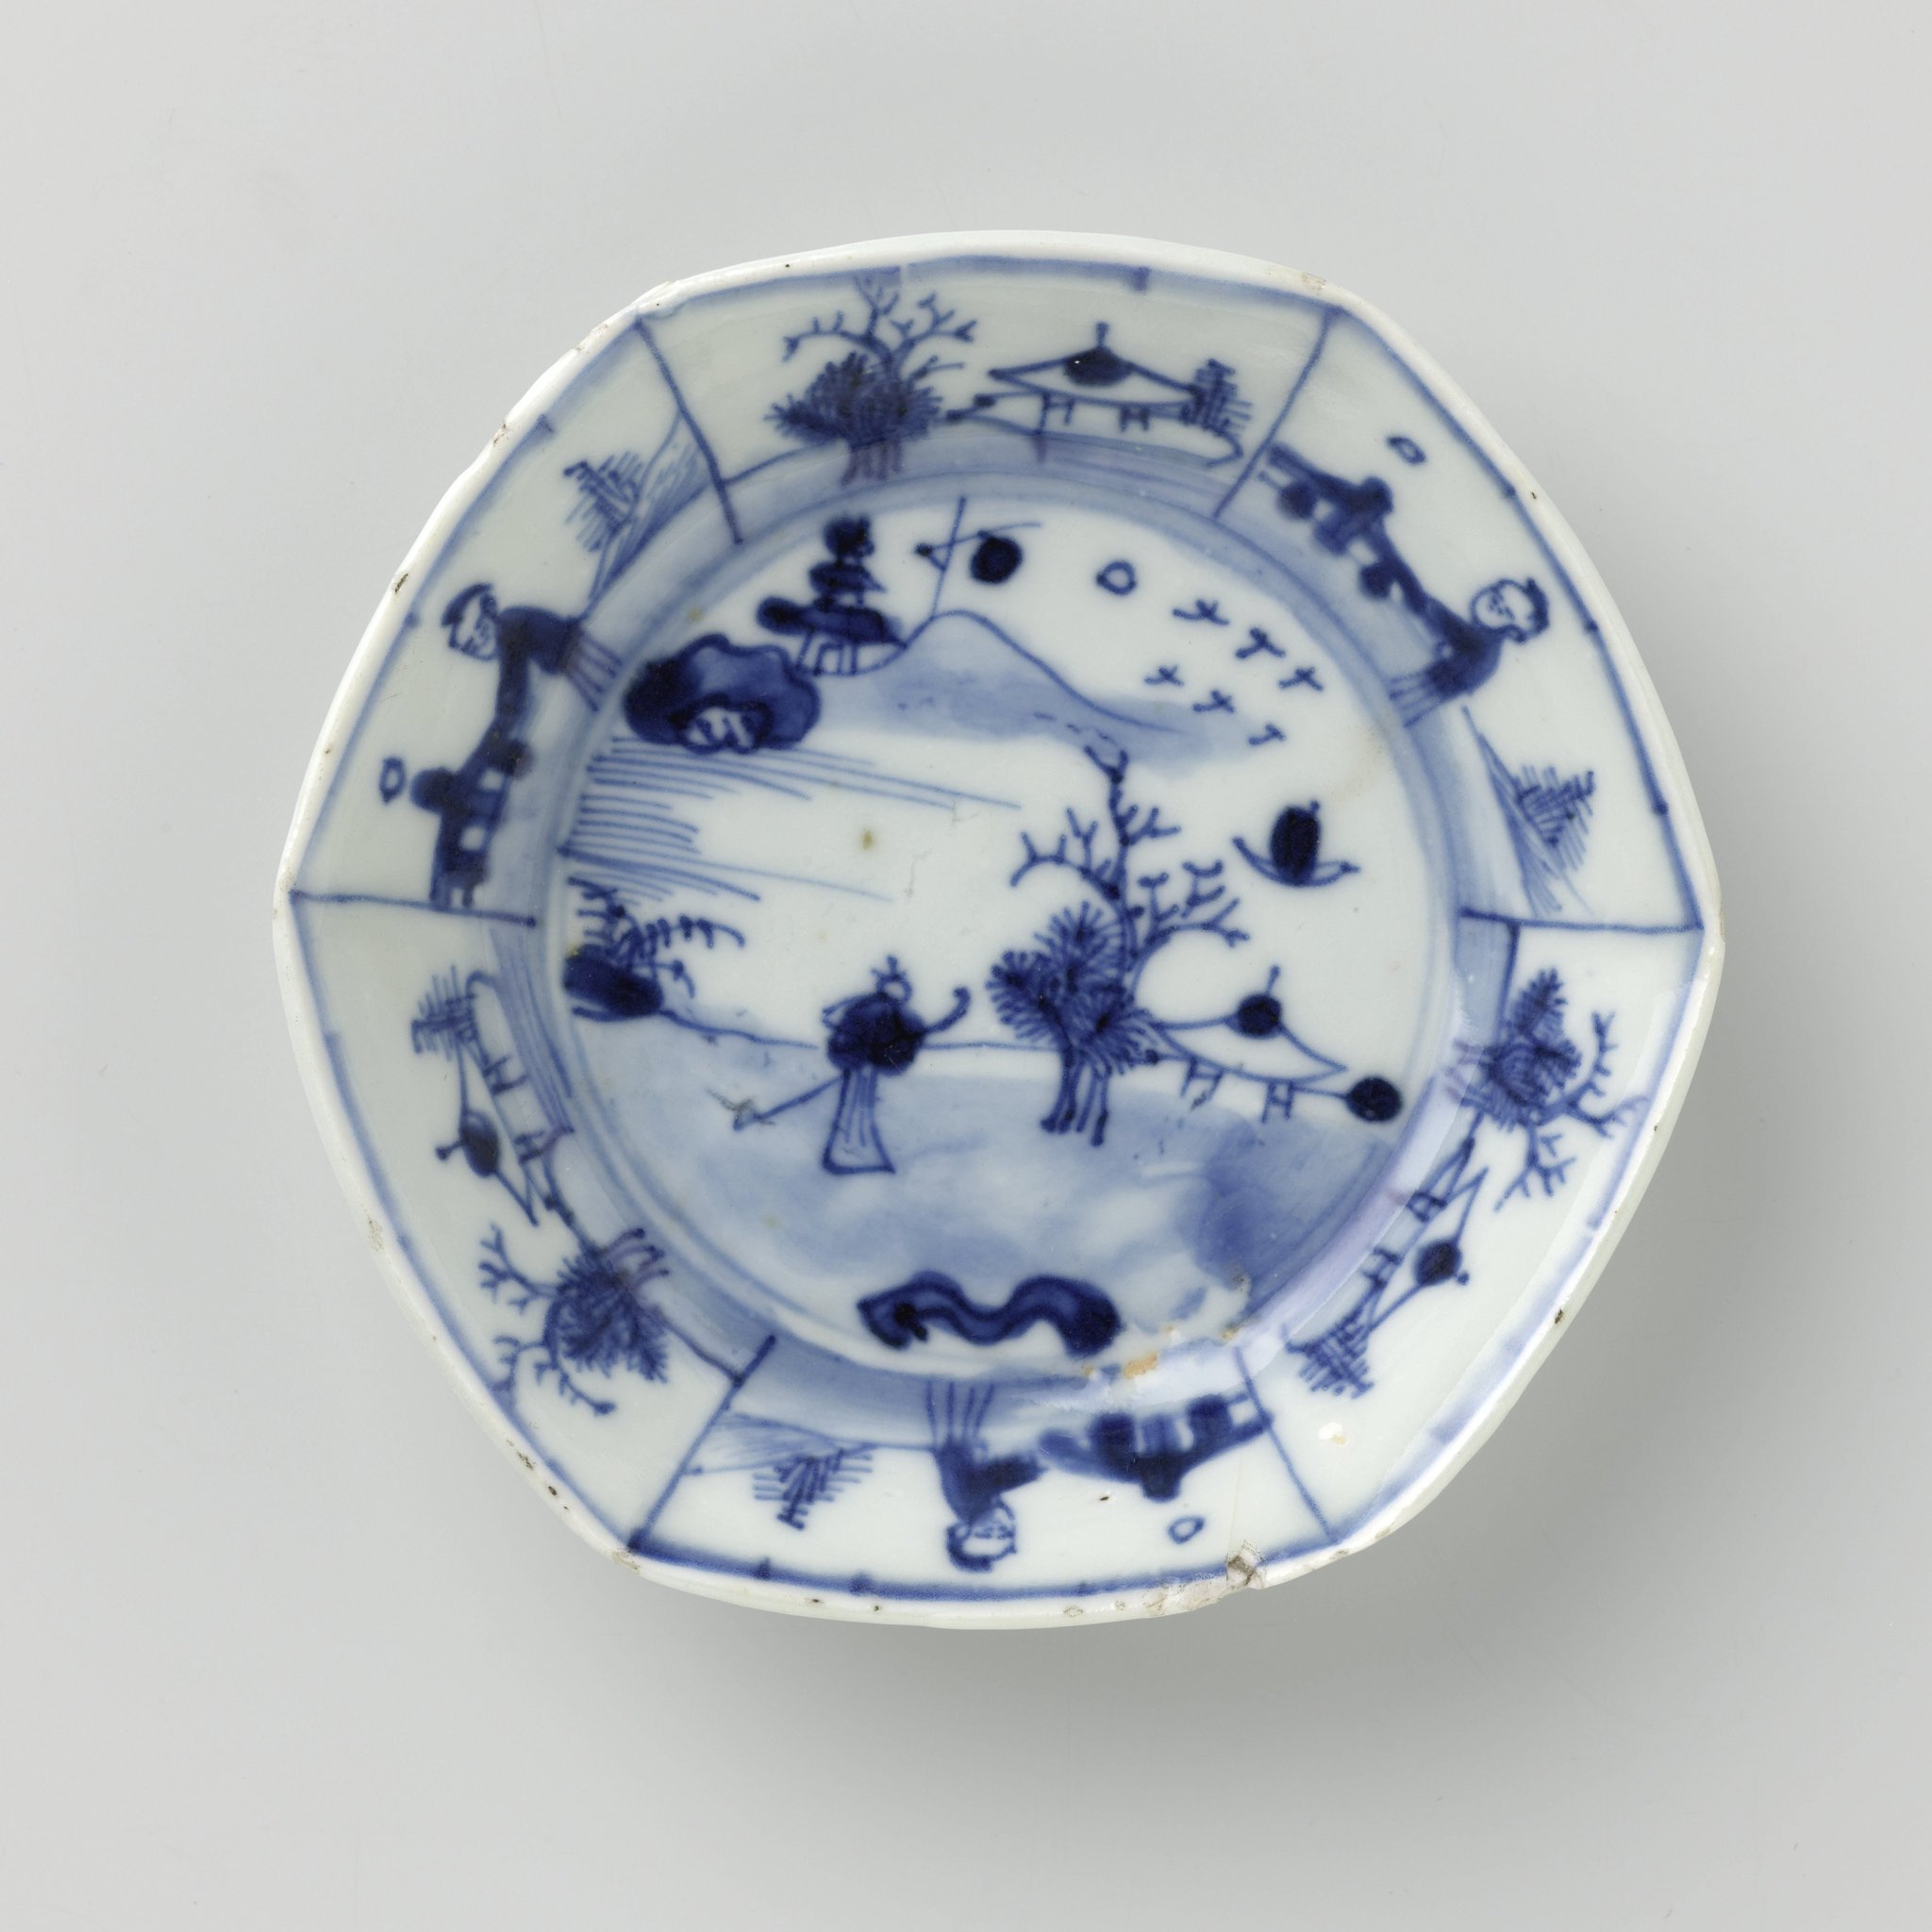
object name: platter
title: Hexagonal saucer-dish with landscapes and figures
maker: Anonymous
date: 1750-1774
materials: cobalt, glaze, paint, porcelain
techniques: firing, forming, turning, vitrification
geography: china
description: Zeshoekige schotel van porselein, beschilderd in onderglazuur blauw. Op het plat een rivierlandschap met paviljoens, bomen en een persoon; de wand is verdeeld in zes vakken met afwisselend een persoon bij een hek en een rivierlandschap met een paviljoen en bomen. Een barst en een chip in de rand. Blauw-wit.